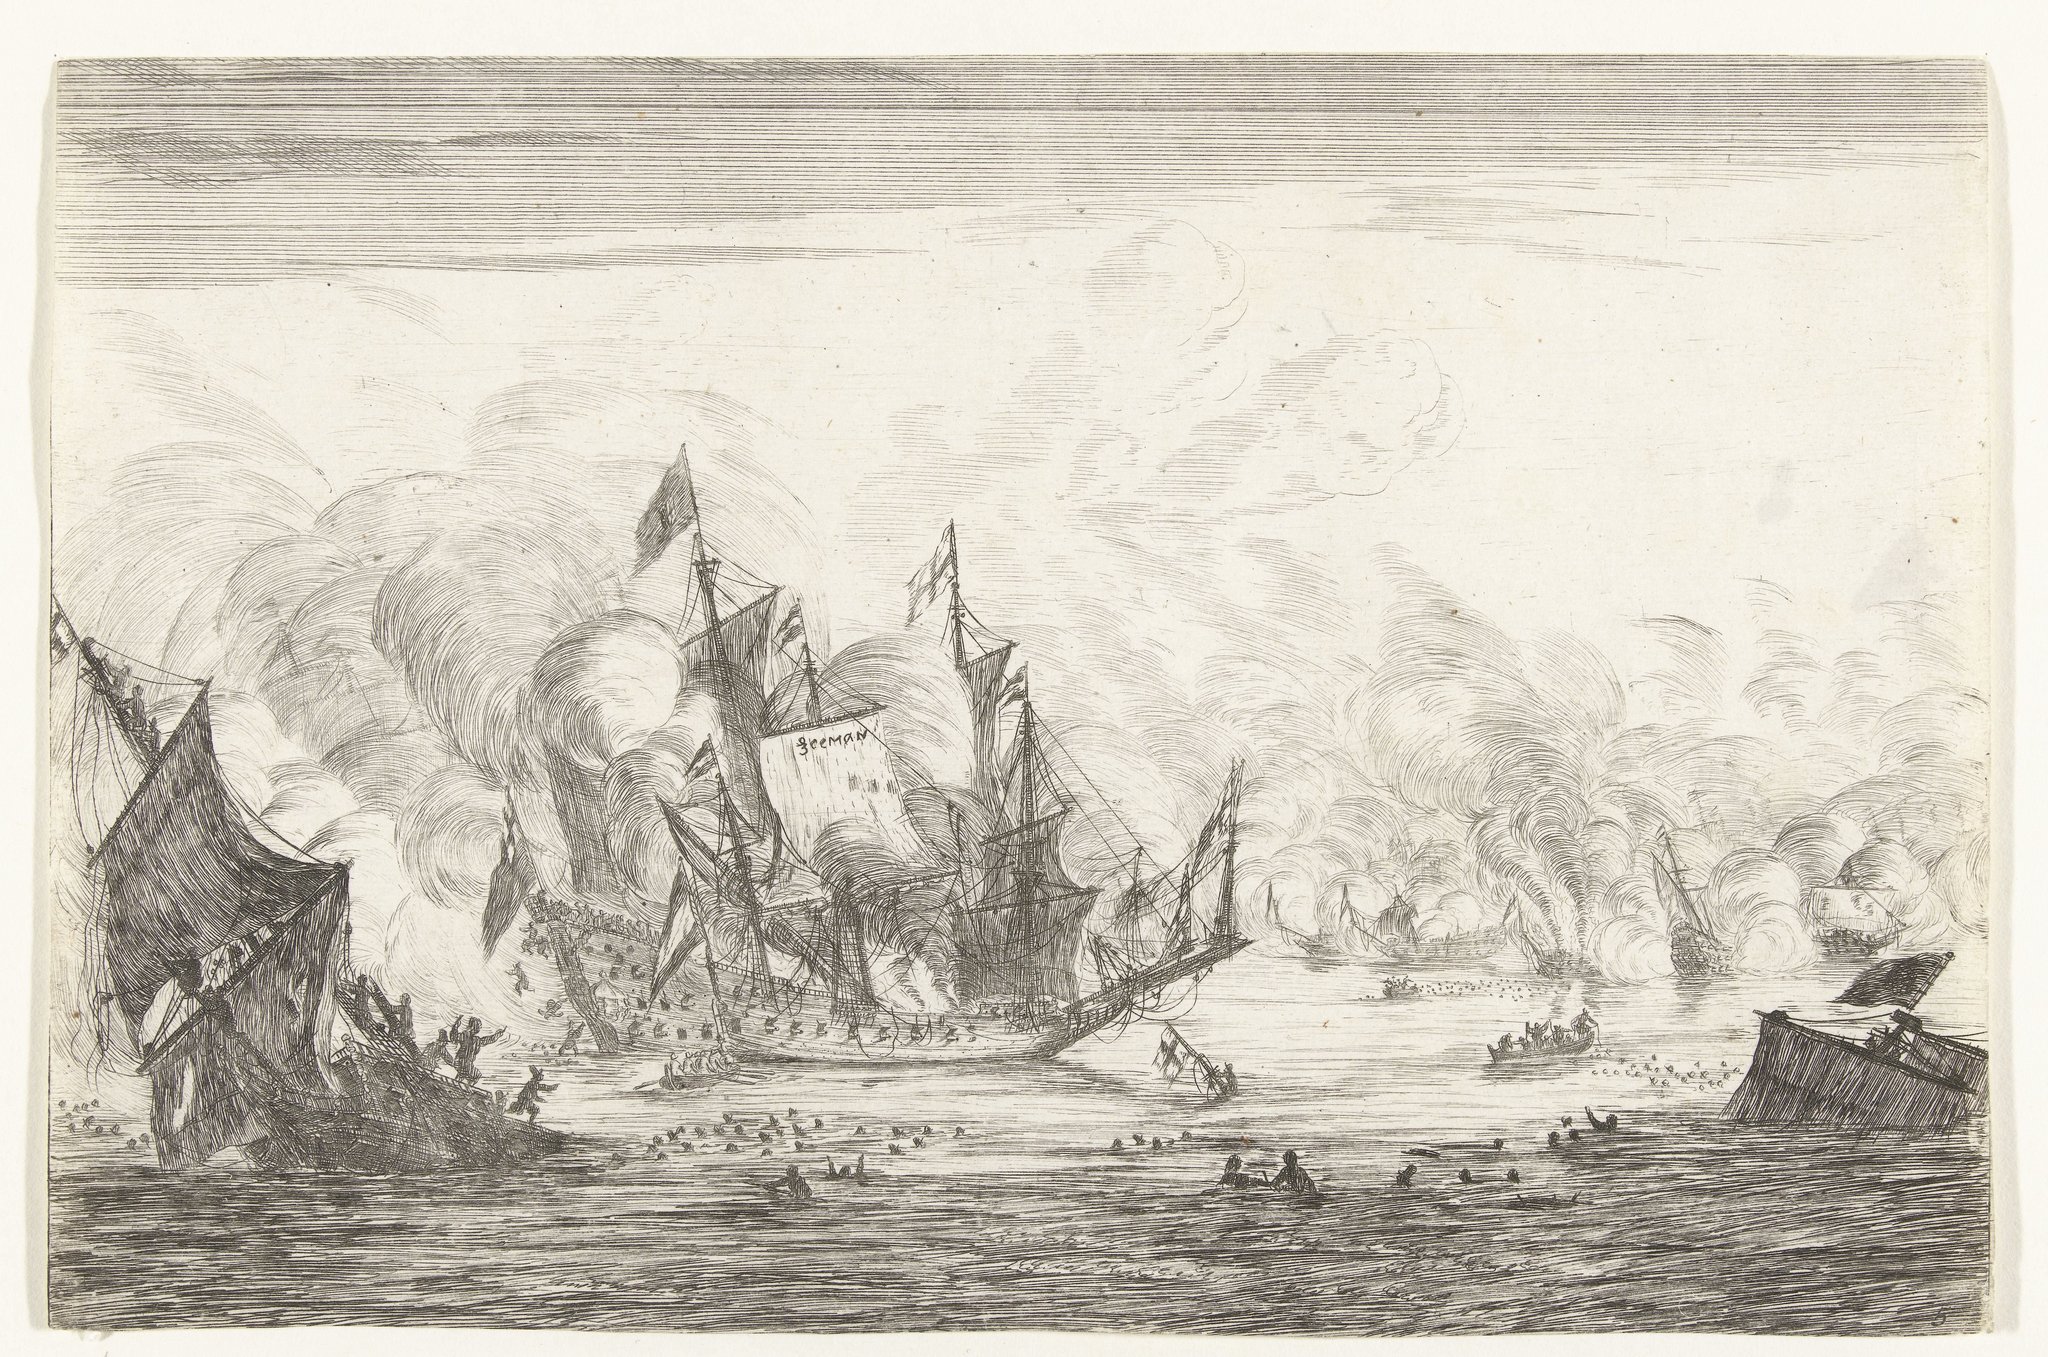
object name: print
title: Nieuwe Scheeps Batalien / Nouvelles inventions de Combats Navaeles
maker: reinier nooms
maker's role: draughtsman, painter, print maker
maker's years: 1623-1664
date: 1652-1654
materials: paper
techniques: drypoint, etching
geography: northern netherlands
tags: battle (+ naval force)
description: Engelse en Hollandse schepen tijdens een zeeslag. Links een zinkend Engels schip en vele opvarenden in het water. Prent nr. 5 in een reeks van zeven genummerde platen van zeeslagen waarvan enkele gerelateerd kunnen worden aan de Eerste Engelse Oorlog van 1652-1654.